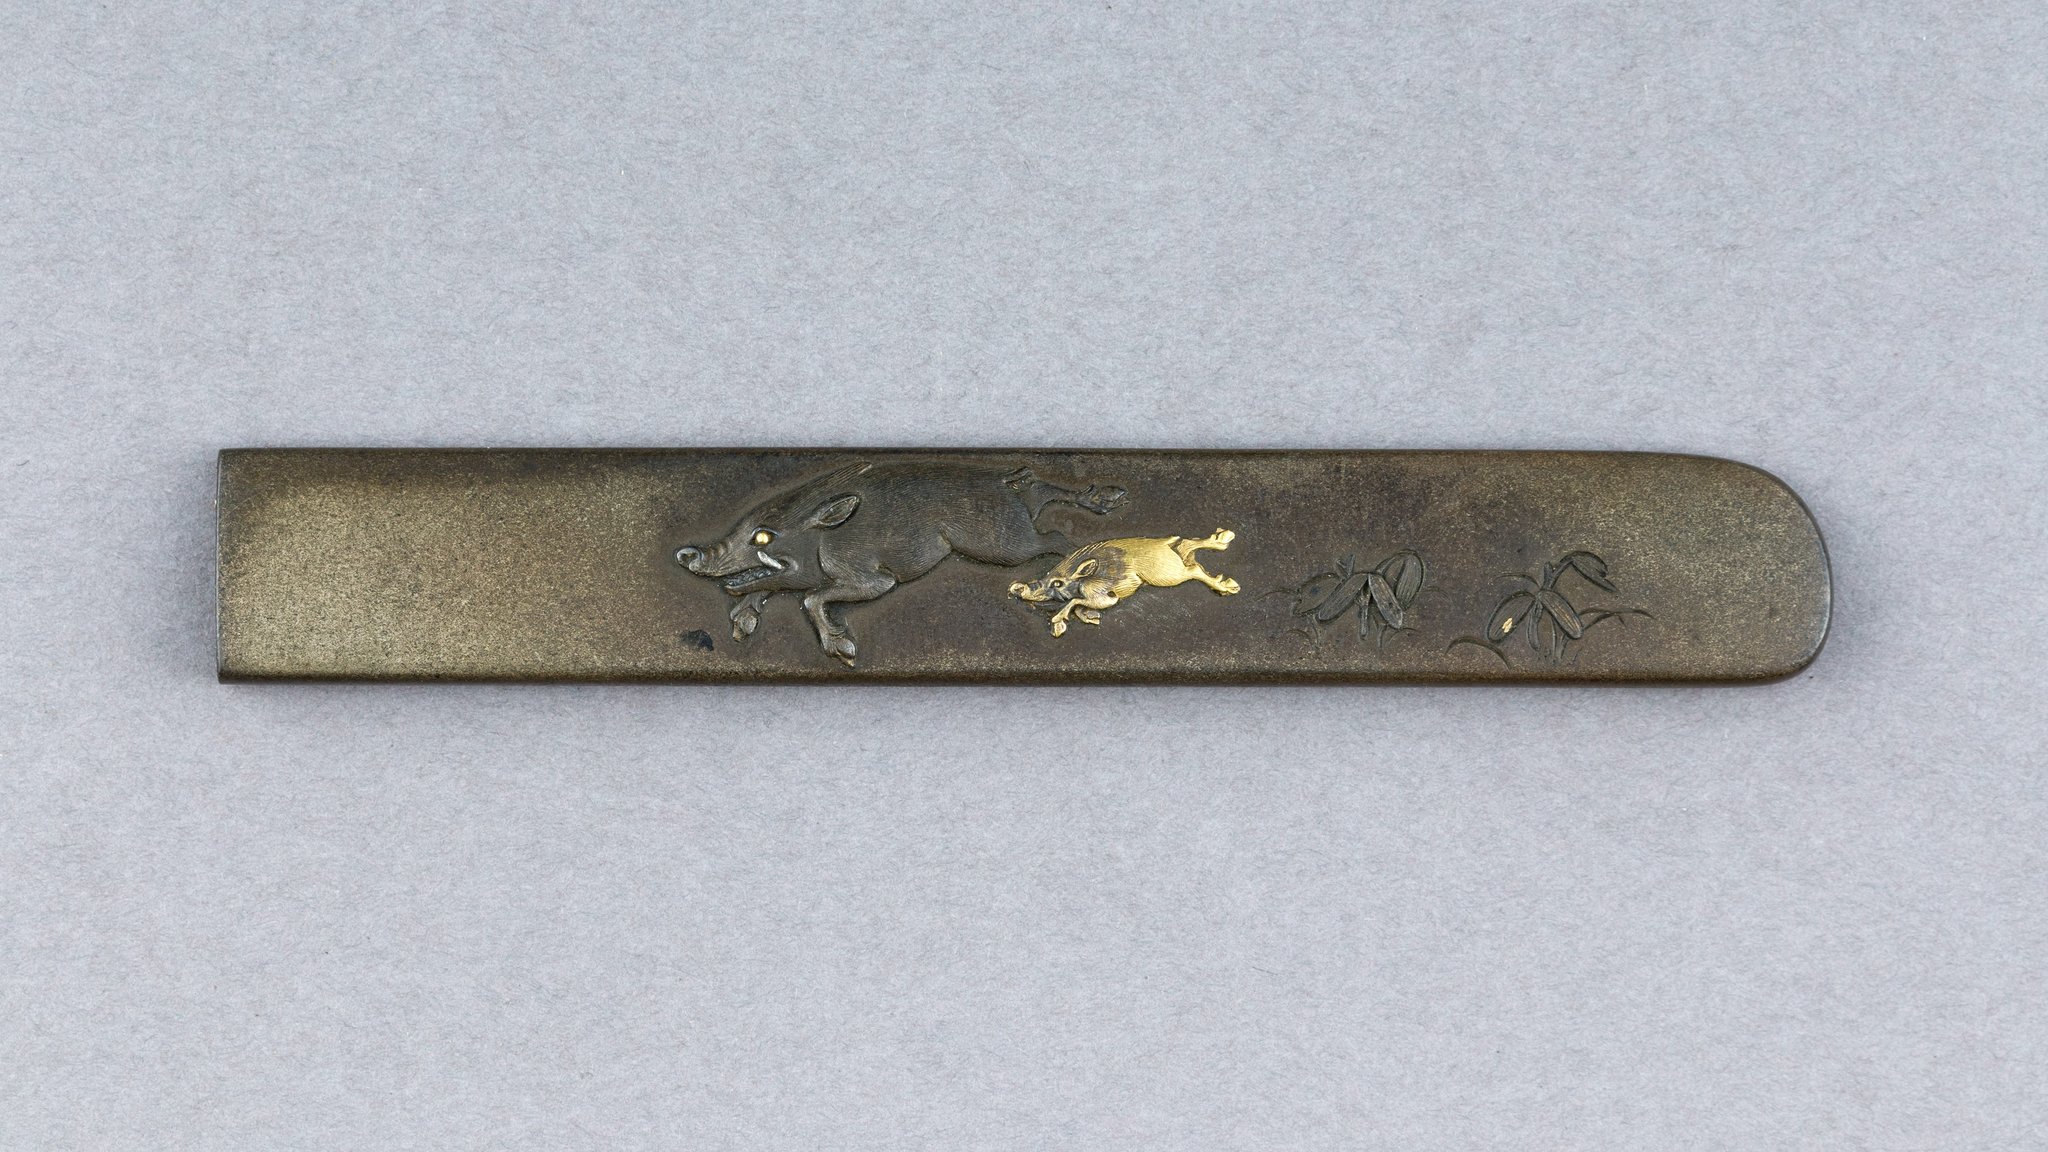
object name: knife handle kozuka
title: Knife Handle (Kozuka)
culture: japanese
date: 1615-1868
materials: silver alloy, gold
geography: japan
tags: boars